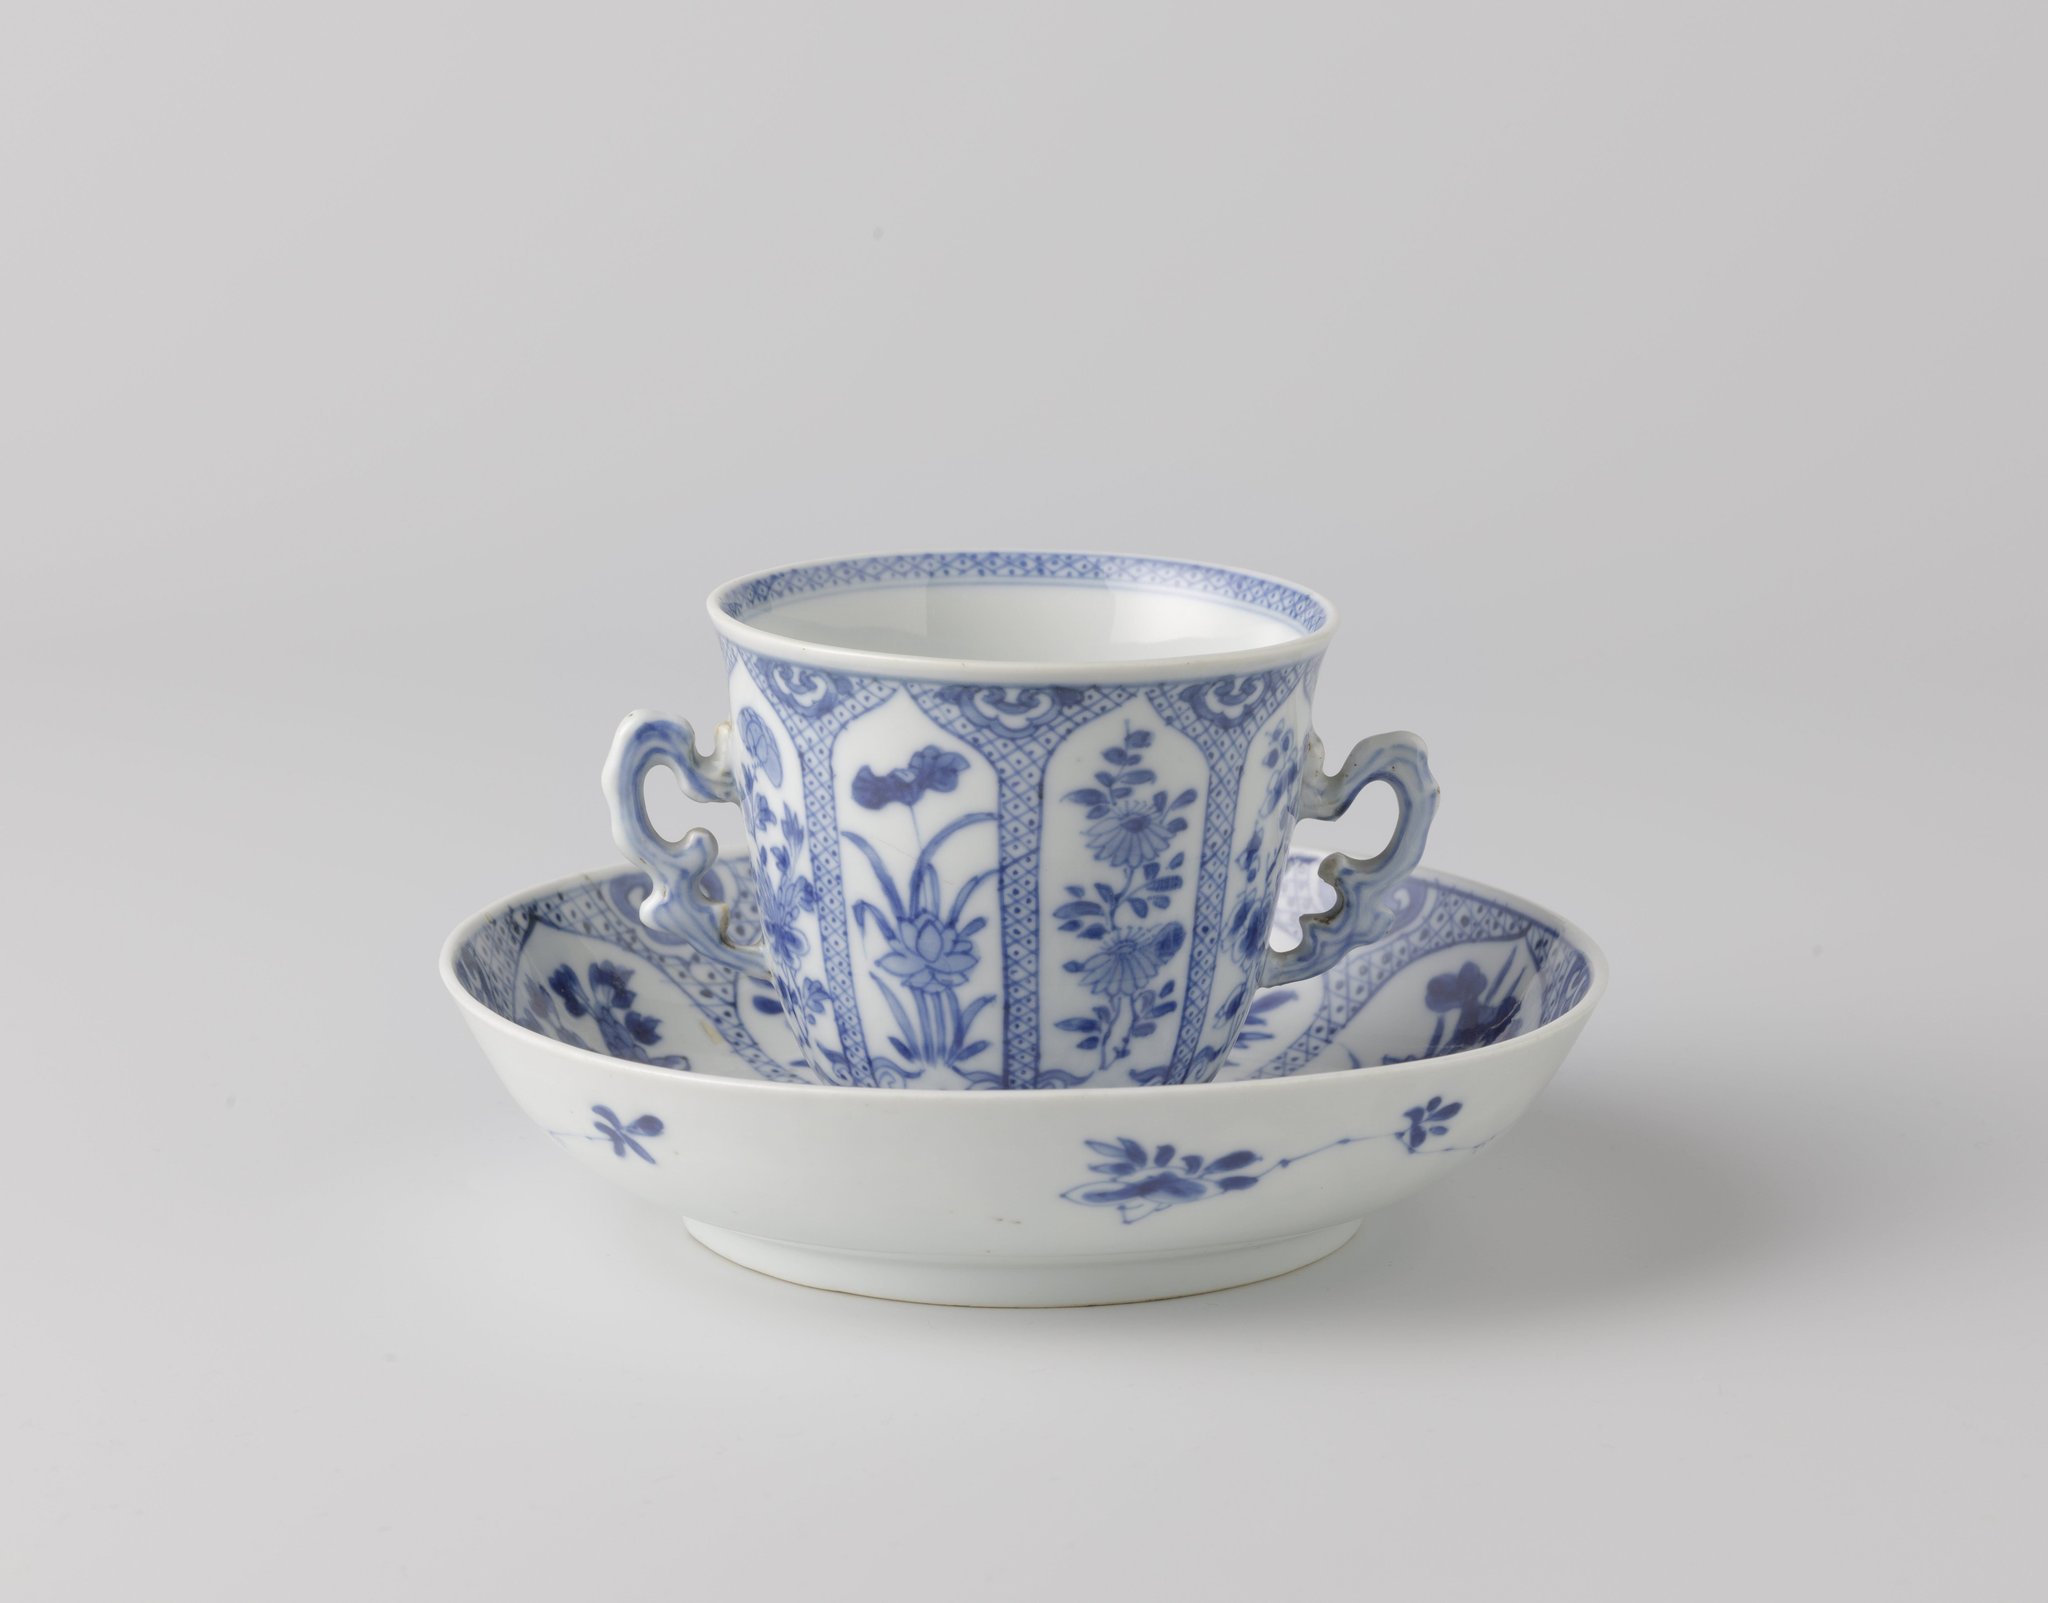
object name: kop en schotel, kop en schotel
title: Cup and saucer with flower sprays in a panel decoration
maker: Anonymous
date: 1700-1724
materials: cobalt, glaze, paint, porcelain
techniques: firing, turning, vitrification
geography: china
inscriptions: mark